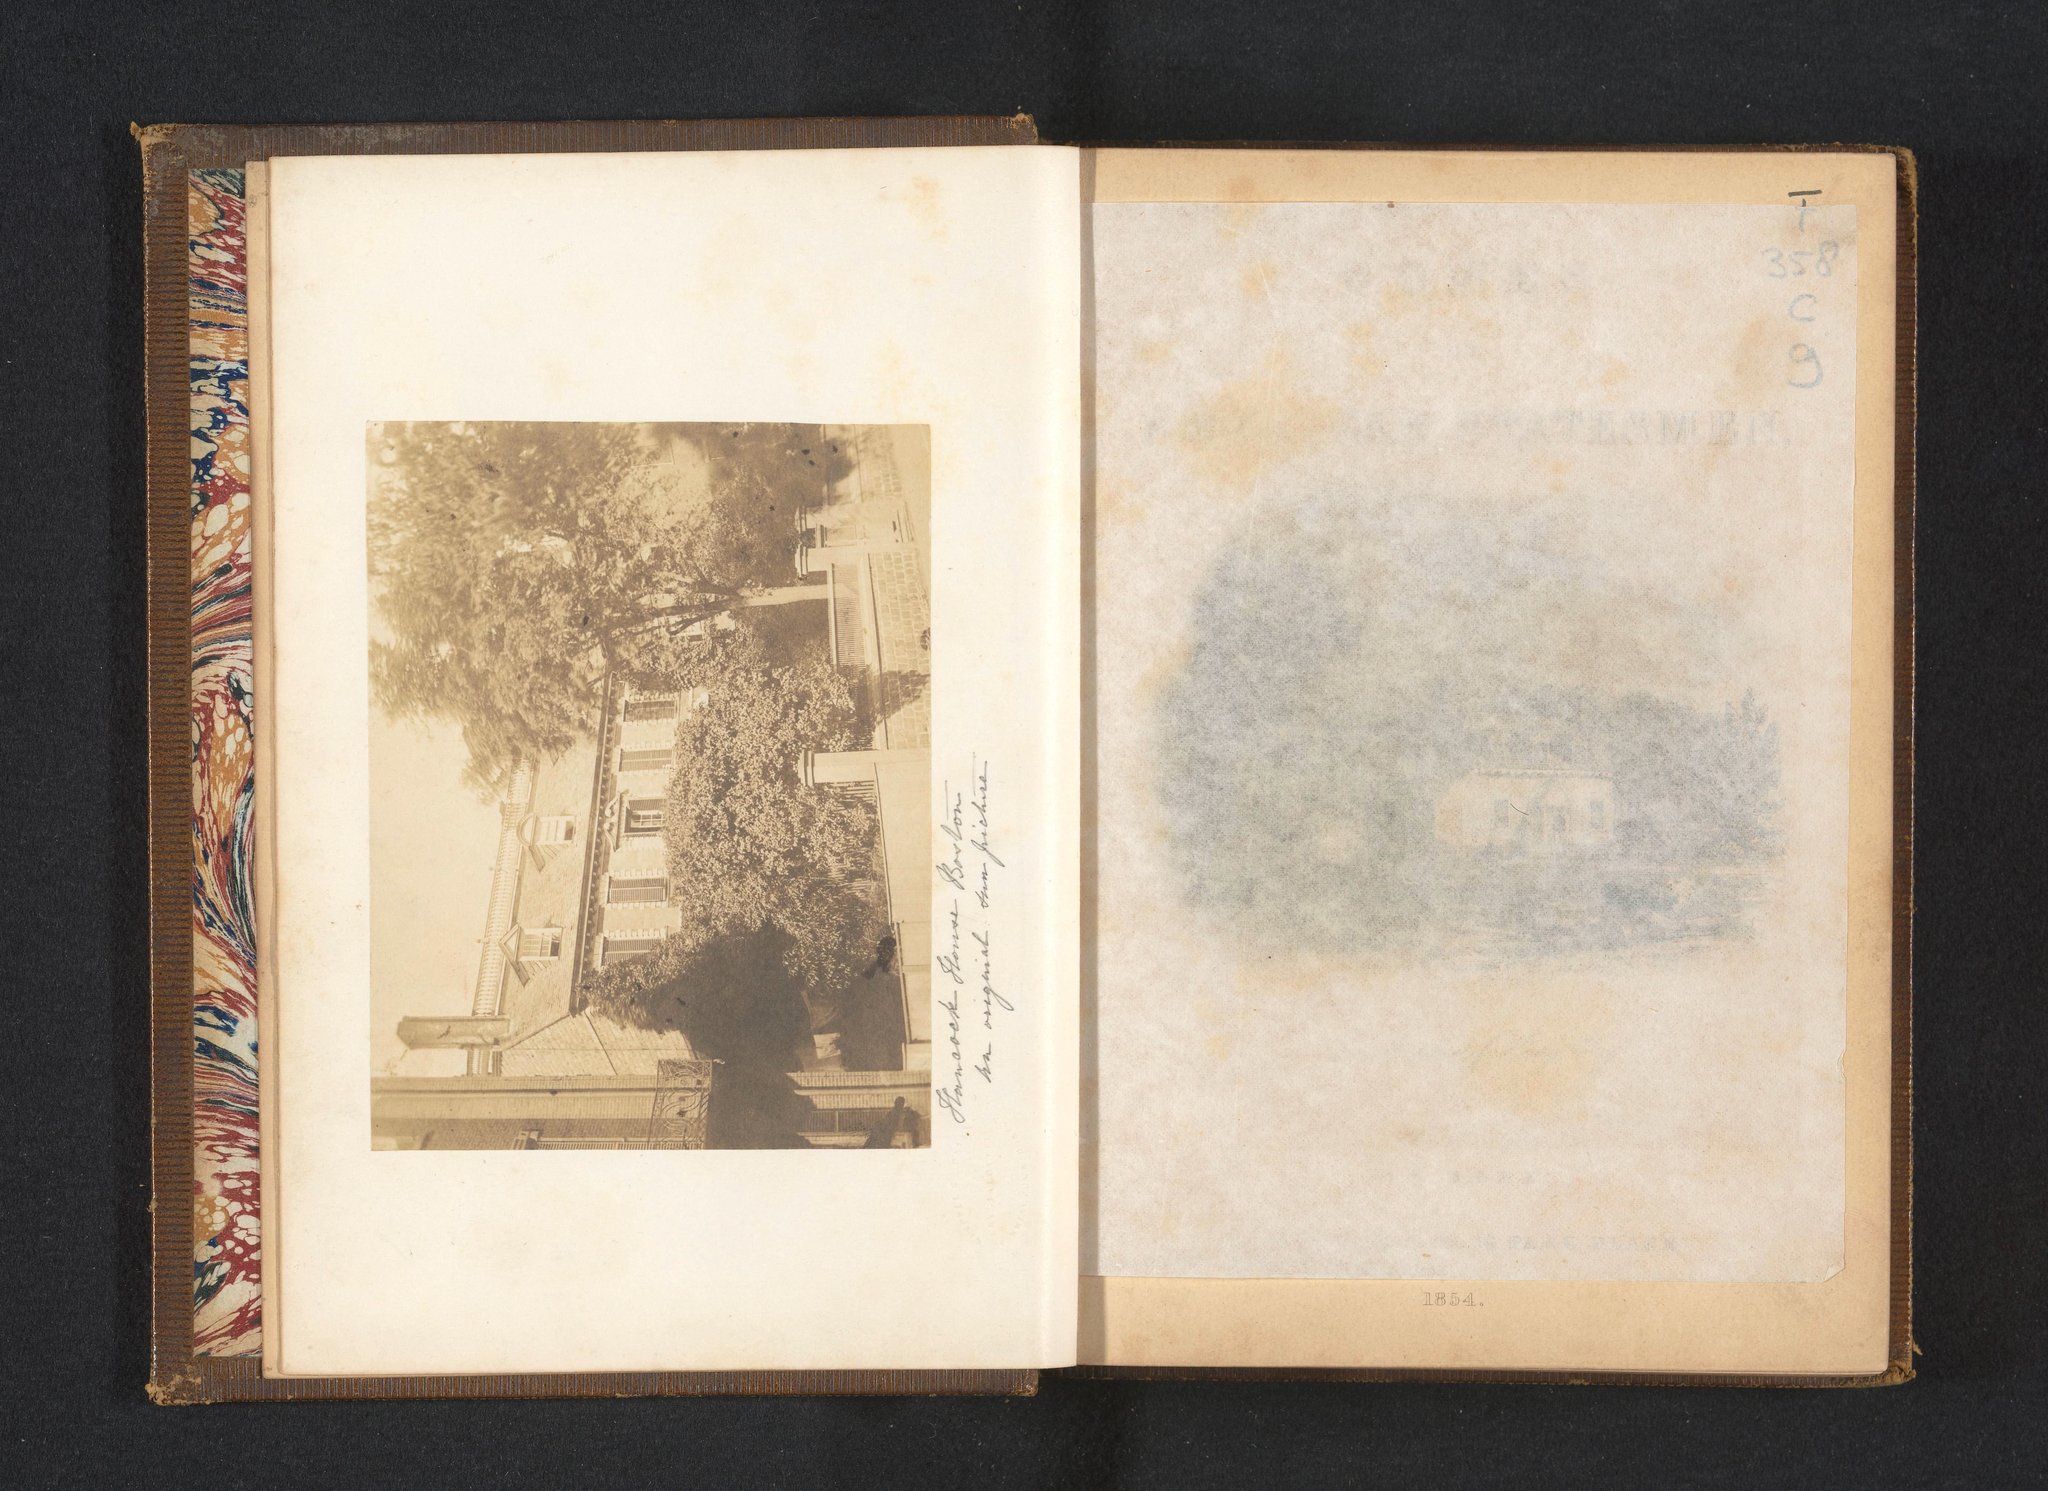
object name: photograph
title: Gezicht op het Hancock House te Boston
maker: john adams whipple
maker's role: fotograaf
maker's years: 1822-1891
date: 1849-1854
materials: photographic support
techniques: salted paper print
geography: washington street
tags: façade (of house or building)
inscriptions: workshop stamp: ‘Whipple's patent/ crystalotype/ Washington st. Boston’, annotation: ‘Hancock House Boston/ an original sun picture’